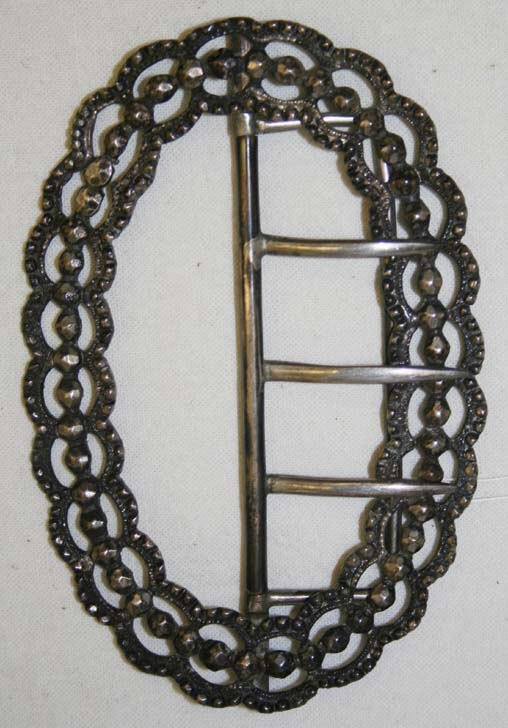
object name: shoe buckle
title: Shoe buckles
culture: irish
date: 1790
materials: metal